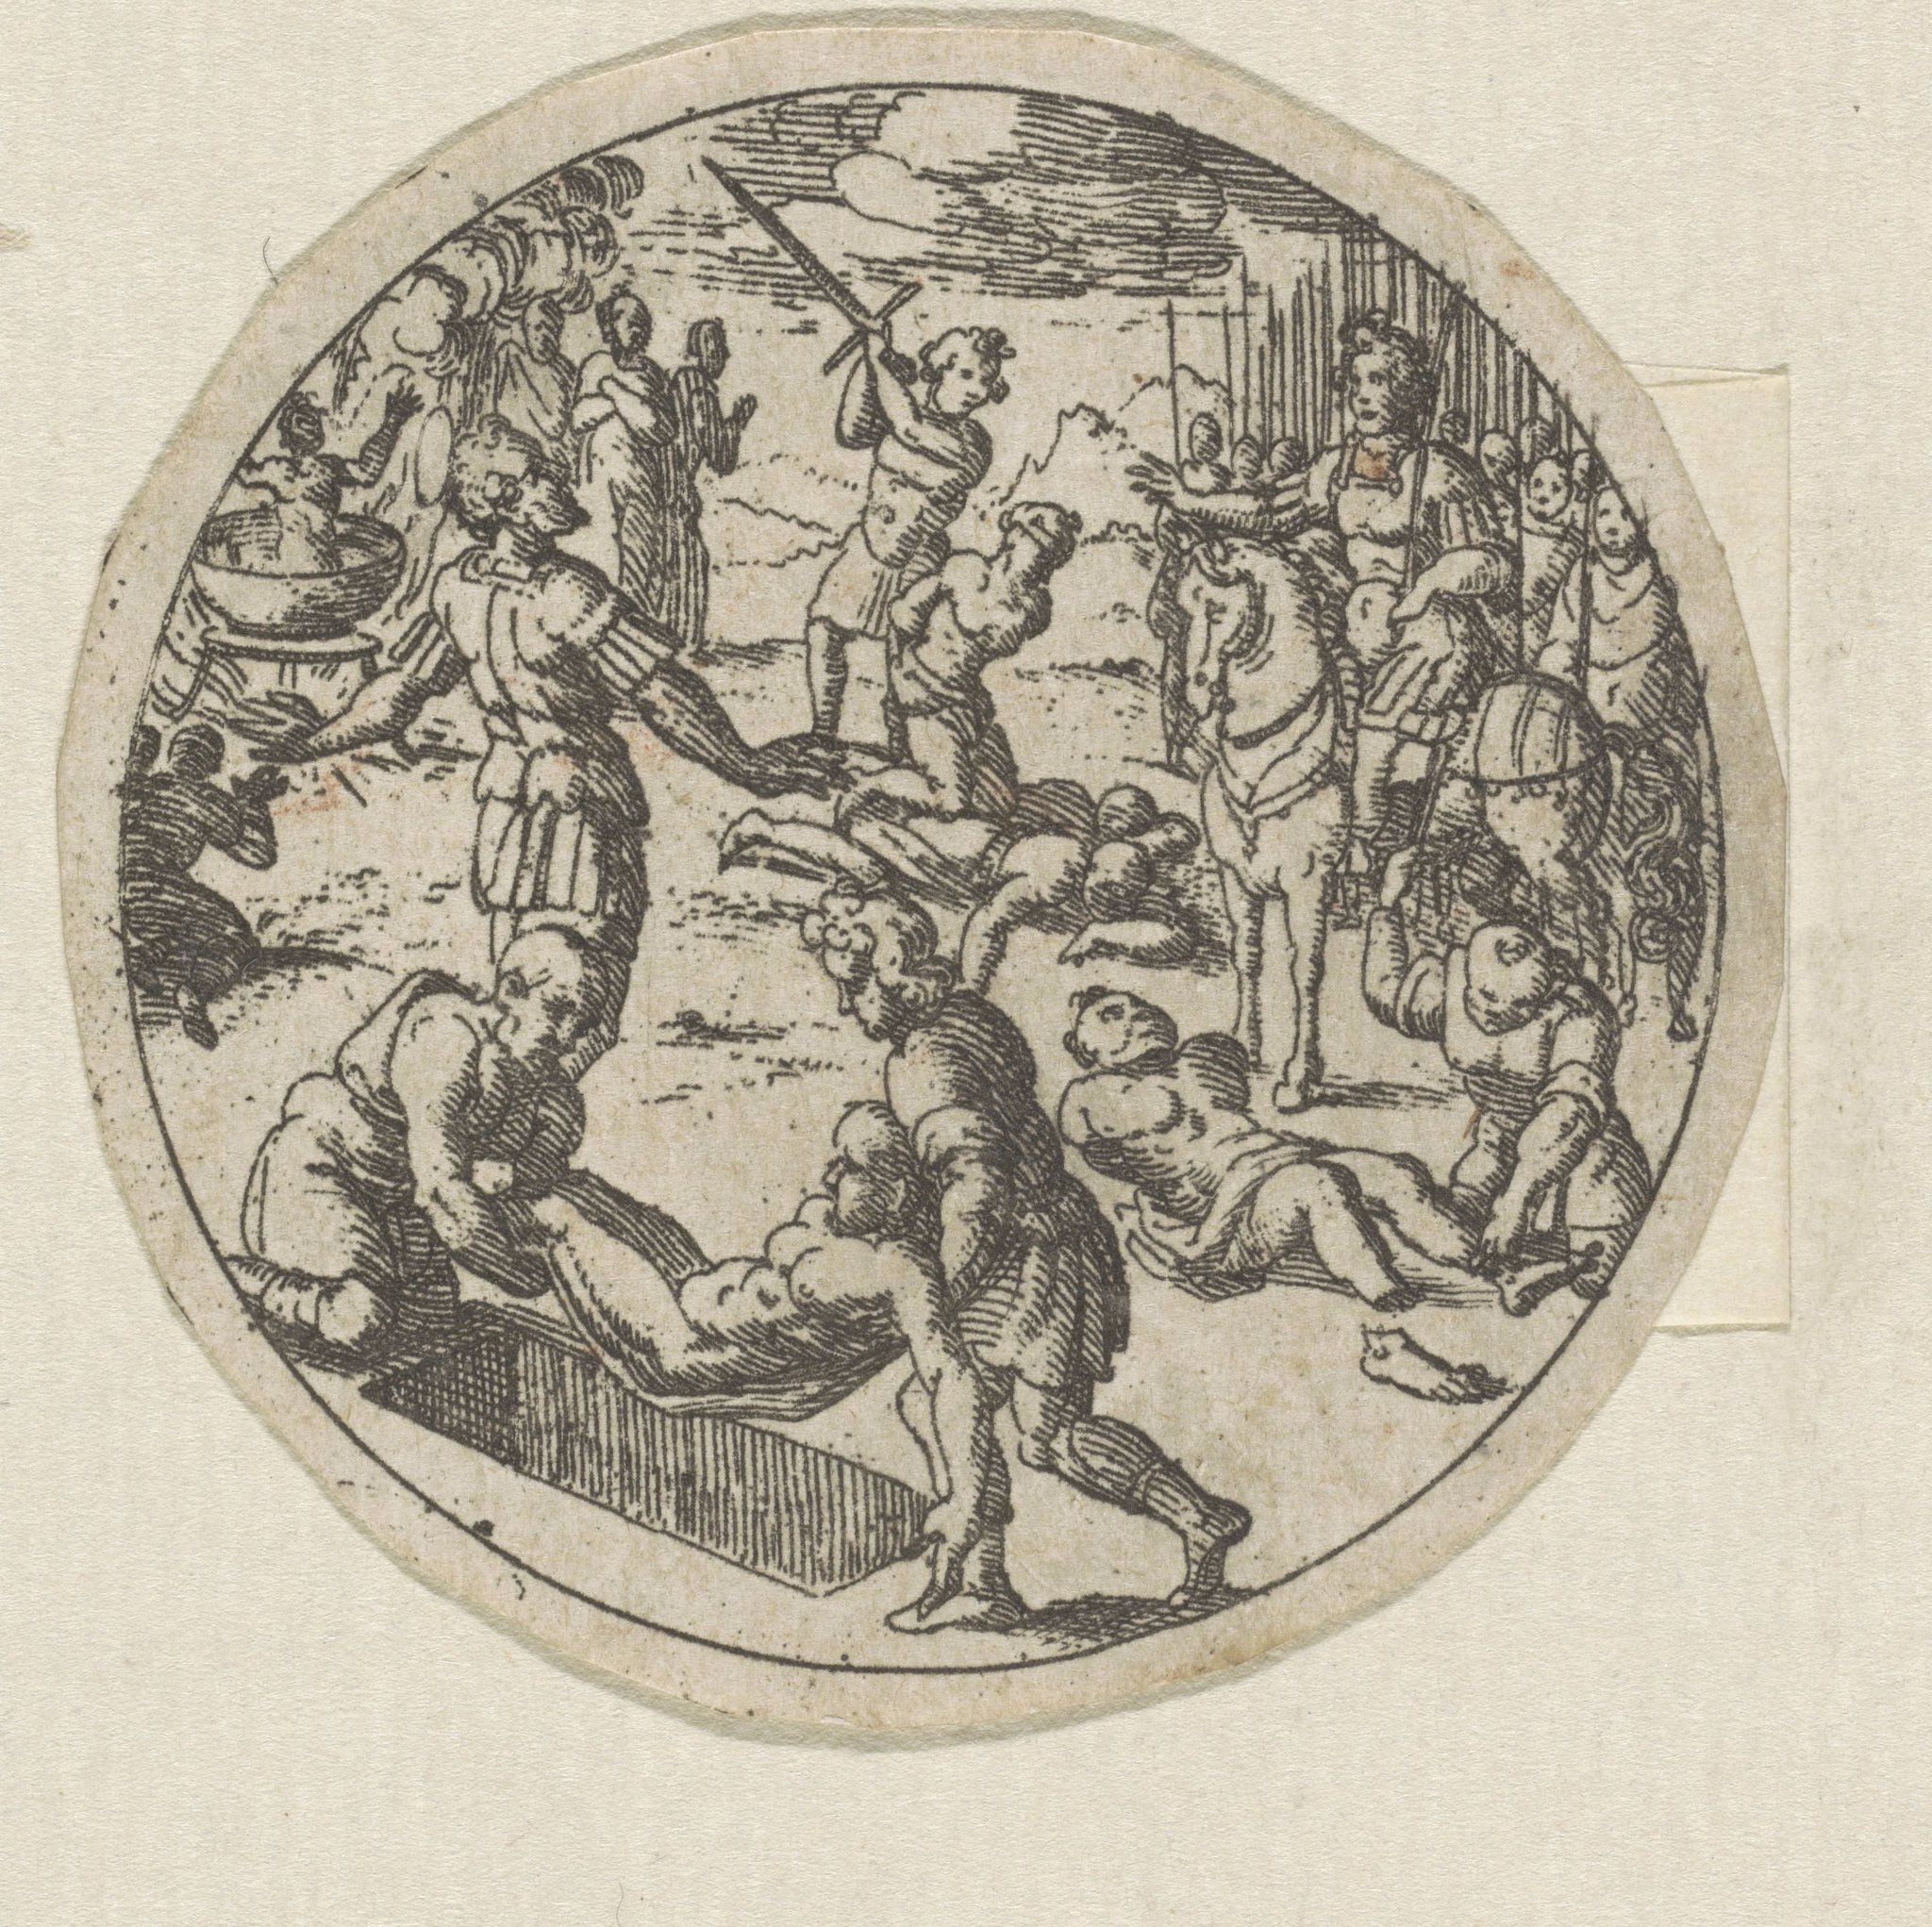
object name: print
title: Martelaarschap van heiligen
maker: Anonymous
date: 1600-1750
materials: paper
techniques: etching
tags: saints, violent death ~ maltreatment, torture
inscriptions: collector's mark: Lugt 240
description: Een officier te paard geeft de opdracht om heiligen te doden. Op de achtergrond wordt iemand gekookt en wordt iemands hoofd afgeslagen. Op de voorgrond wordt iemand de voeten afgehakt en iemand wordt begraven.